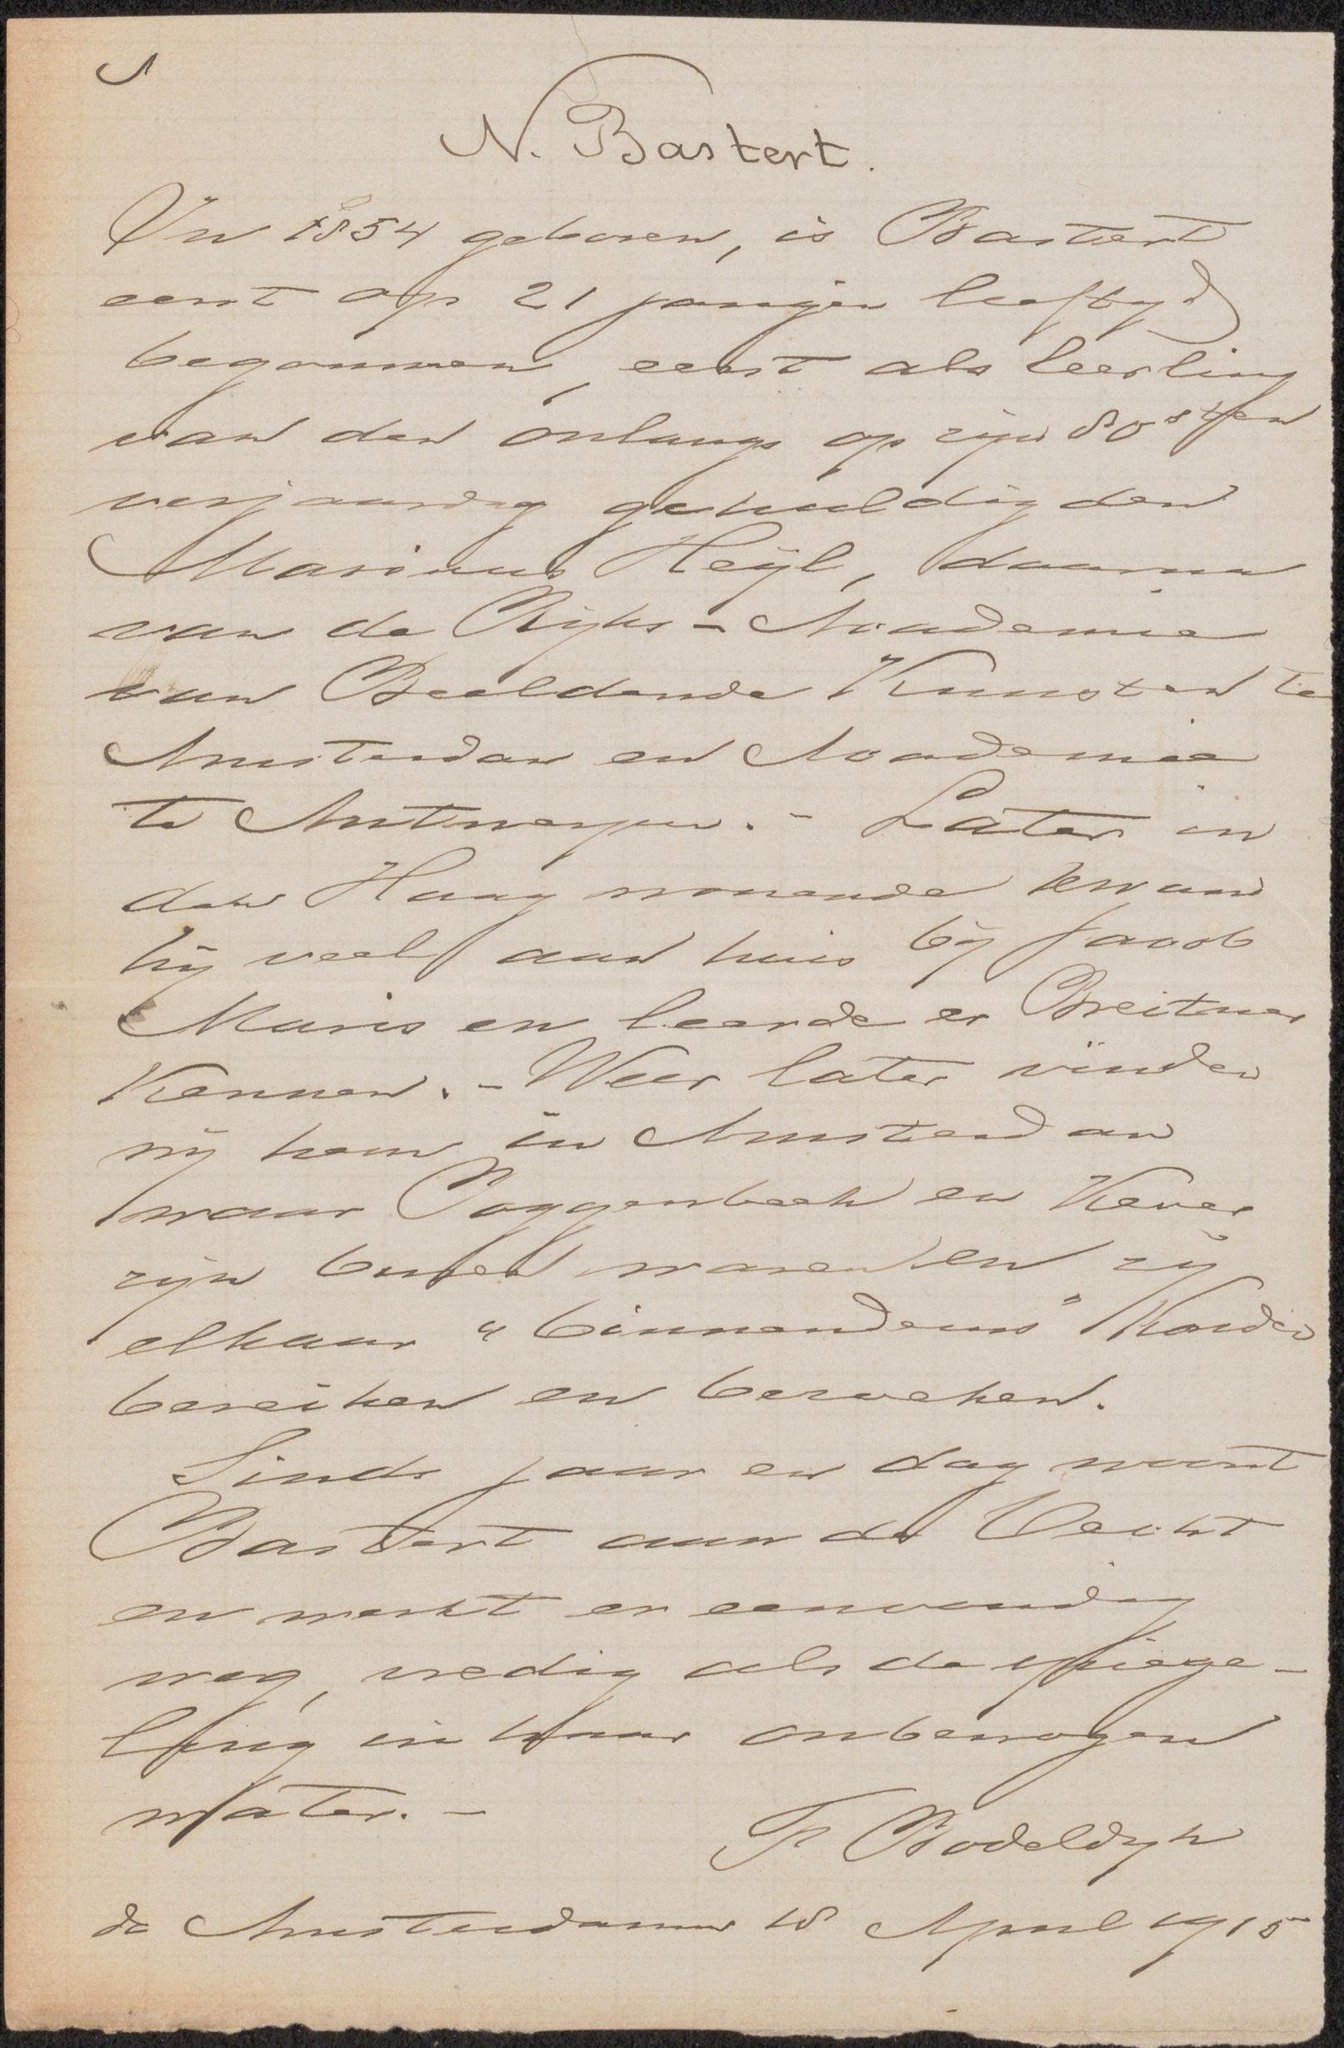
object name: manuscript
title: Handschrift betreffende Nicolaas Bastert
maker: felicien bobeldijk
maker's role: draughtsman, print maker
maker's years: 1876-1964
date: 1915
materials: ink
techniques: pen, writing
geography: amsterdam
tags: rotterdam, george hendrik breitner, utrecht, marinus heijl, amsterdam, painter, print maker, draughtsman, jacob simon hendrik kever, jacob maris, geo poggenbeek, nicolaas bastert, schools, education, tuition of the artist (in general), the hague